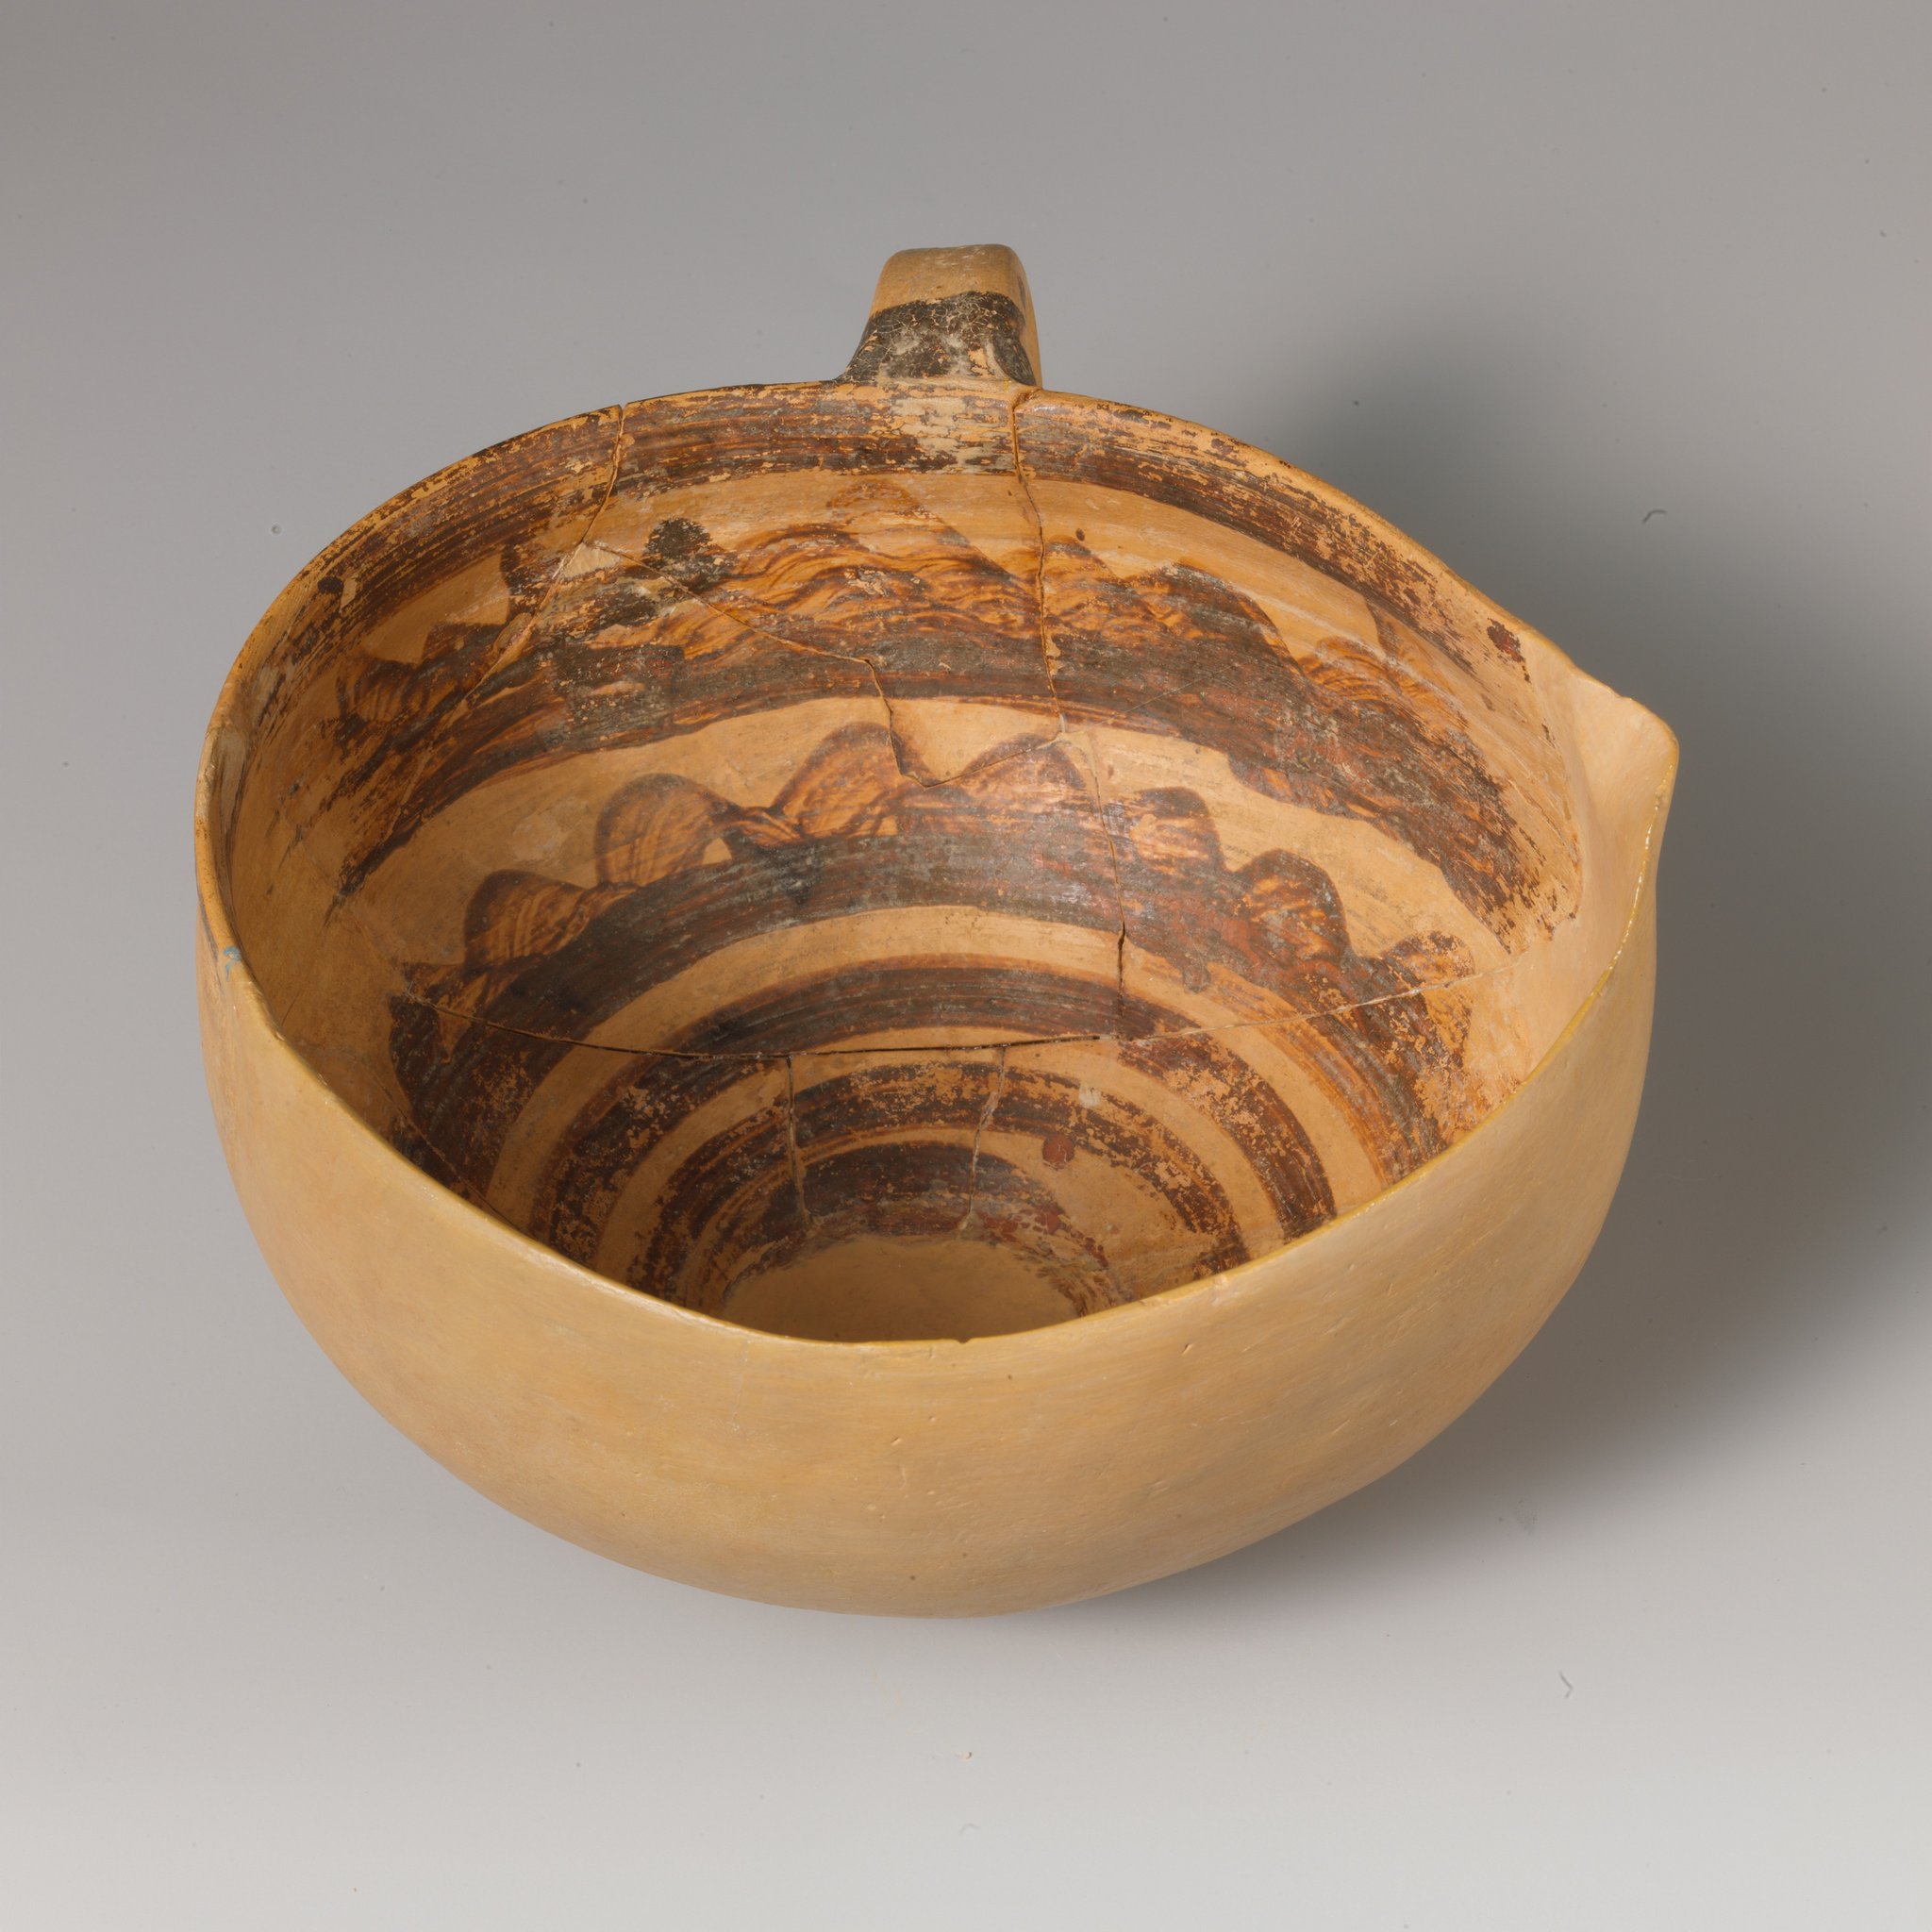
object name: cup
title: Terracotta one-handled cup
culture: minoan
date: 1600-1450 BCE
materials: terracotta